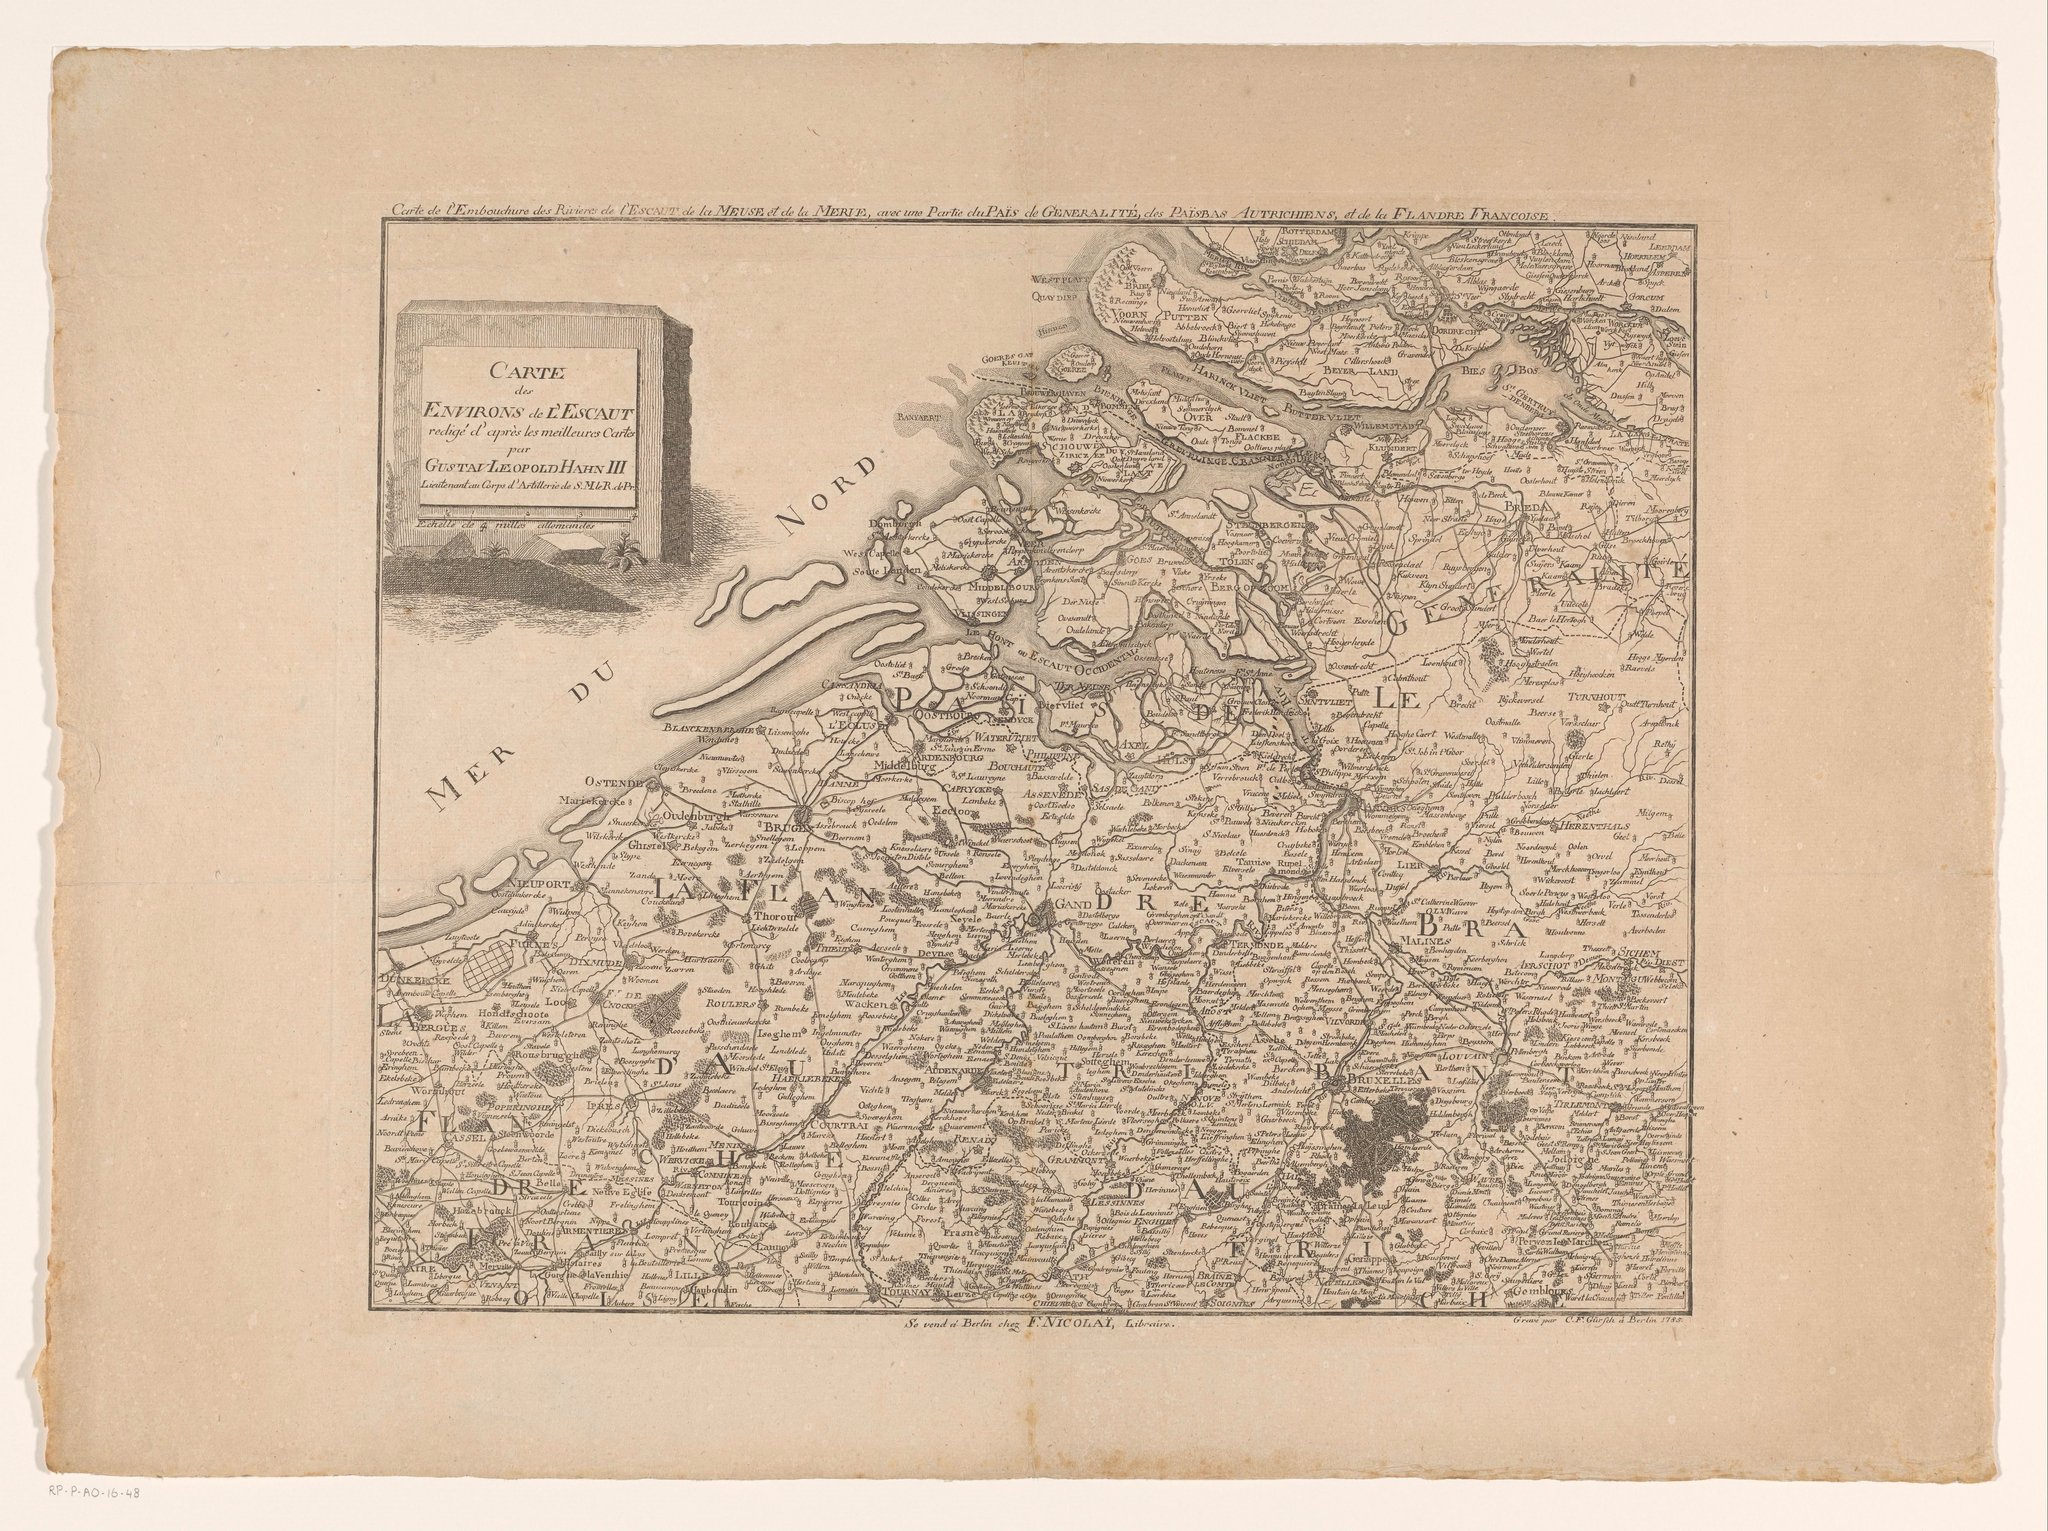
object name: print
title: Carte des environs de l'Escaut (...) / Carte de l'embouchure des rivieres de l'Escaut de la Meuse et de la Merve, avec une partie du Païs de Generalité, des Païsbas Autrichiens, et de la Flandre Francoise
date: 1785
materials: paper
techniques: engraving, etching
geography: berlin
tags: maps of separate countries or regions, zeeland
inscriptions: collector's mark: Lugt 19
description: Kaart van Vlaanderen en een deel van Zeeland. Linksboven de titelcartouche met schaalstok: Echelle de 4 milles allemandes.